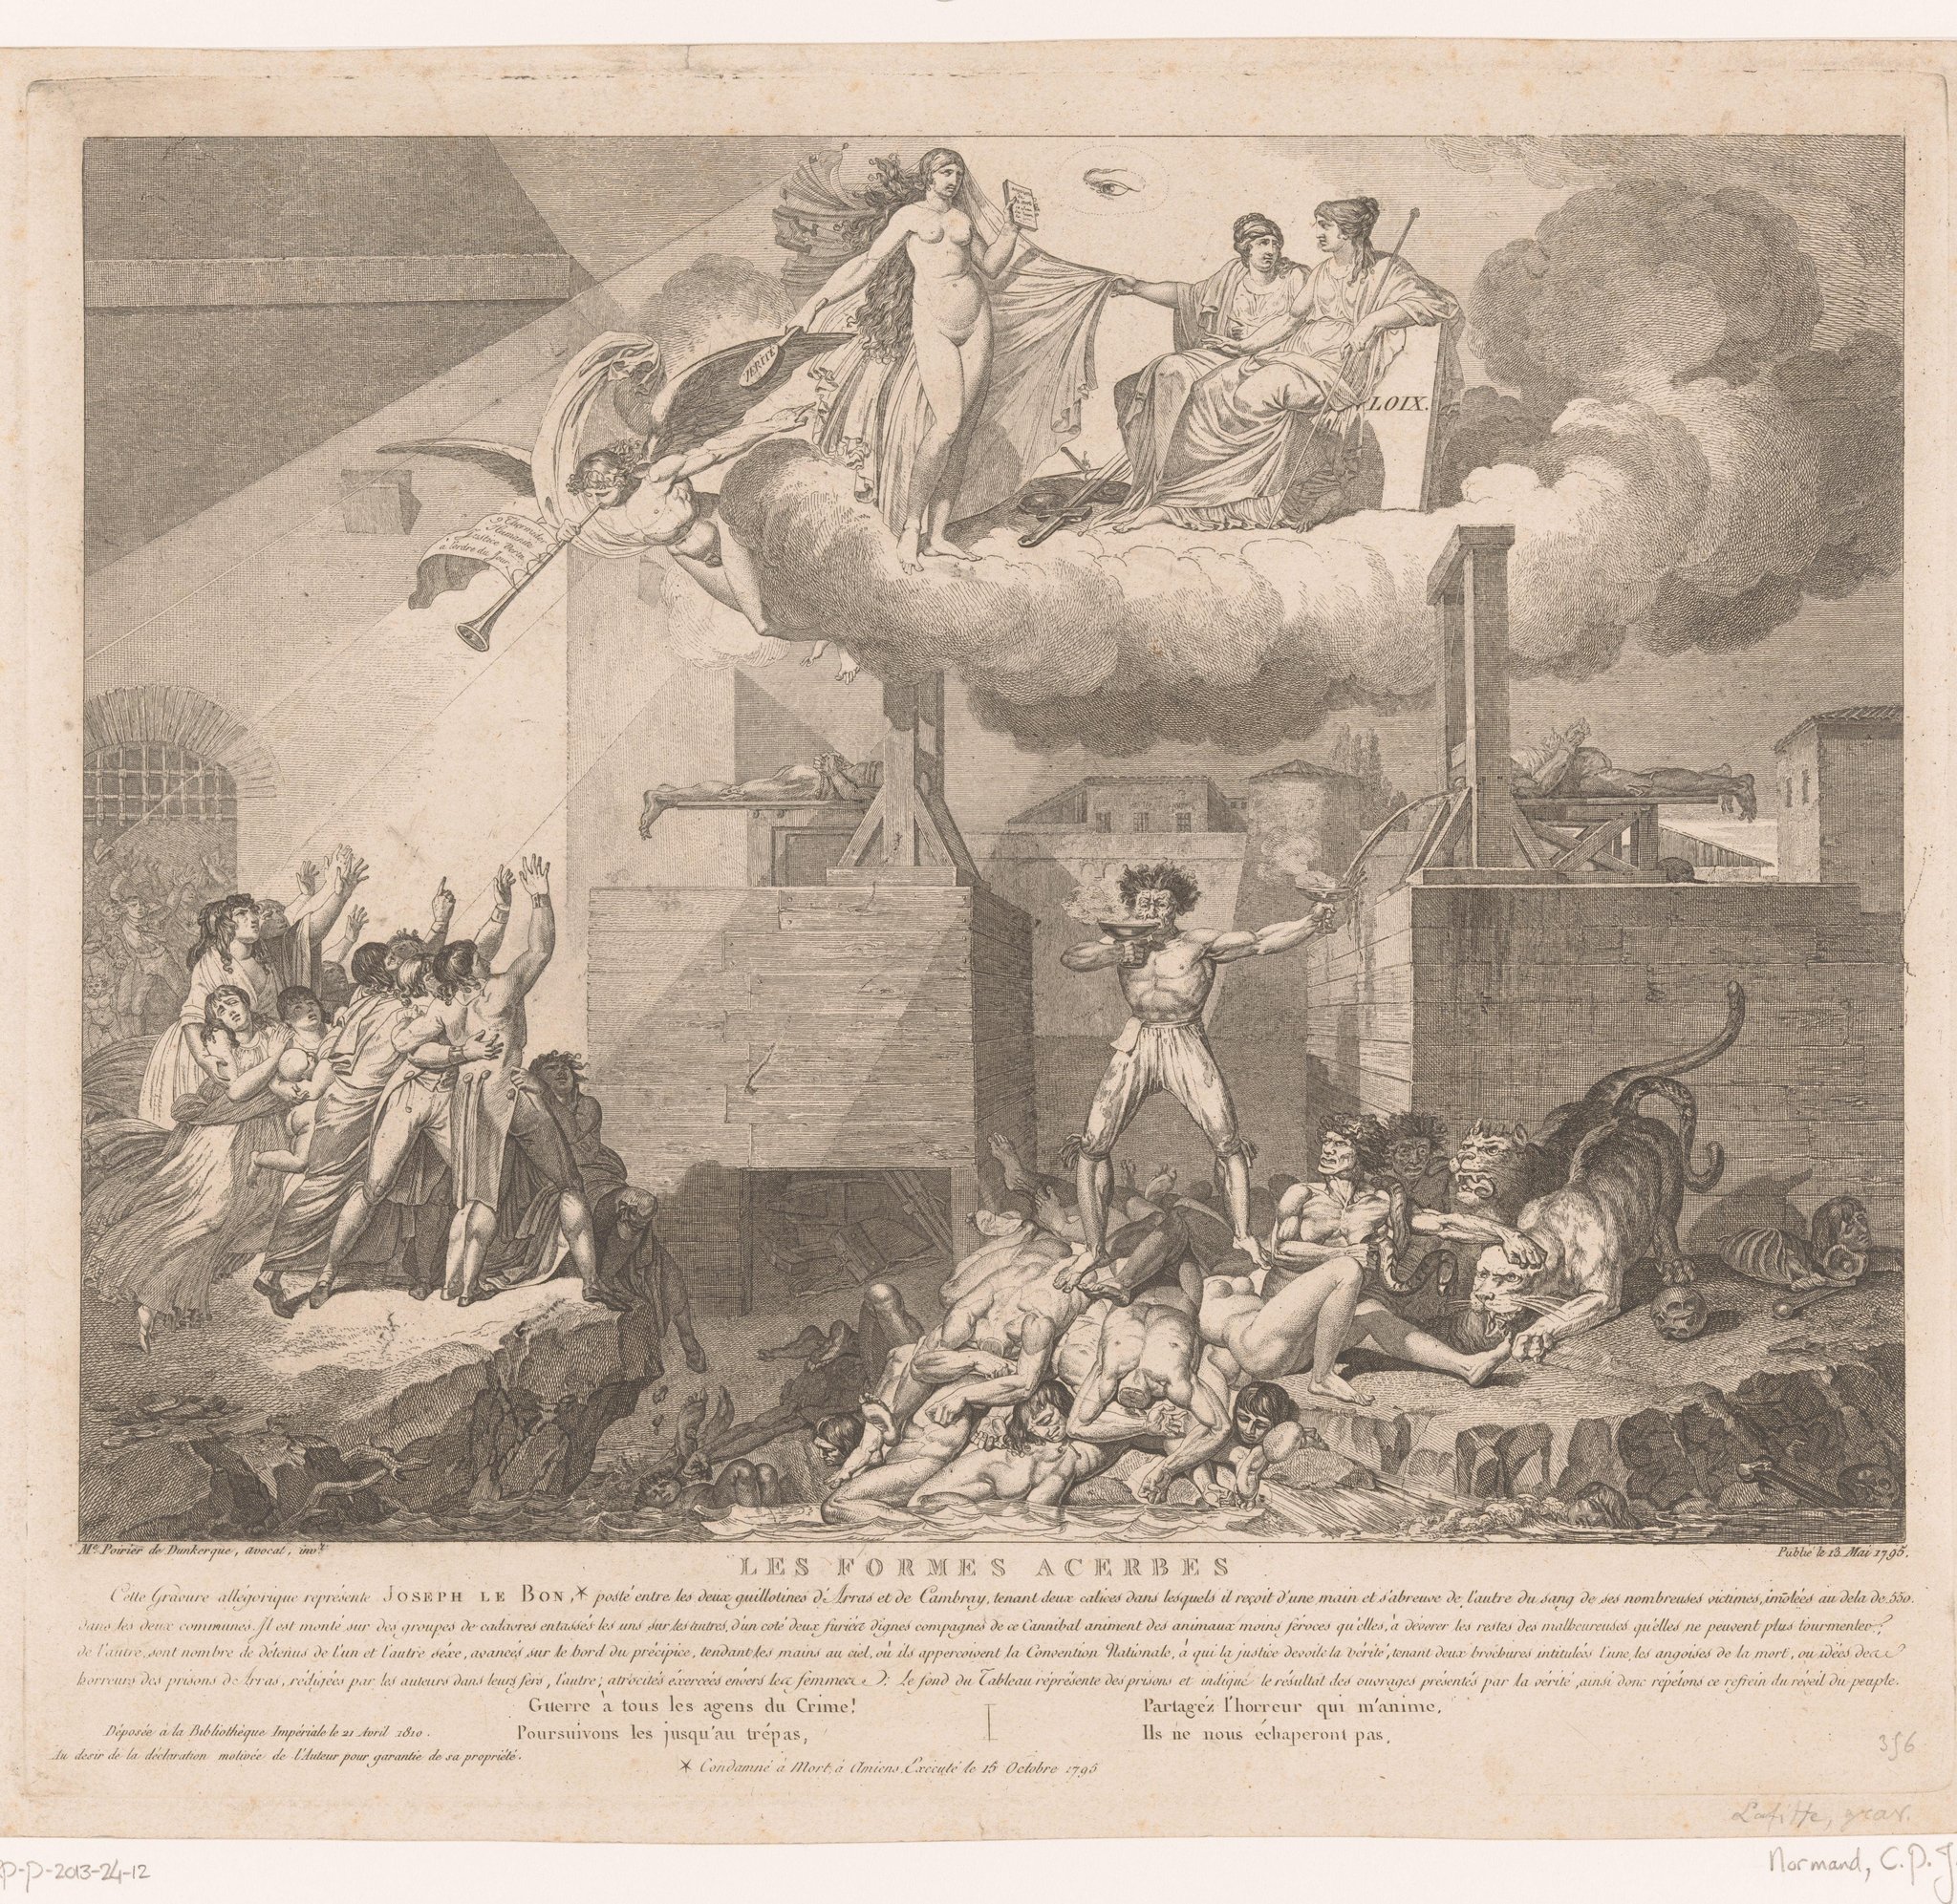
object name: print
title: Allegorie op het schrikbewind van de revolutionair Joseph le Bon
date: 1795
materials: paper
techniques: etching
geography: france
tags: violent death ~ beheading by guillotine, symbols and allegories of law; 'legge', 'legge civile' (ripa), the all-seeing eye, triangle with eye ~ symbol of god the father, time denuding truth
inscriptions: collector's mark: Lugt 2760, collector's mark: Lugt 2228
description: Allegorie op het schrikbewind van de Franse revolutionair Joseph le Bon in de jaren 1793-1794. Le Bon staande tussen twee guillotines en op de lichamen van zijn slachtoffers drinkt uit een kelk het bloed van zijn slachtoffers. In de hemel onthult de Tijd de naakte Waarheid, de Wet kijkt toe. Daarboven het Alziende Oog. Onder de titel een onderschriftt van vier regels en een vierregelig vers in het Frans. De prent is van mei 1795, in oktober werd Le Bon zelf terechtgesteld.